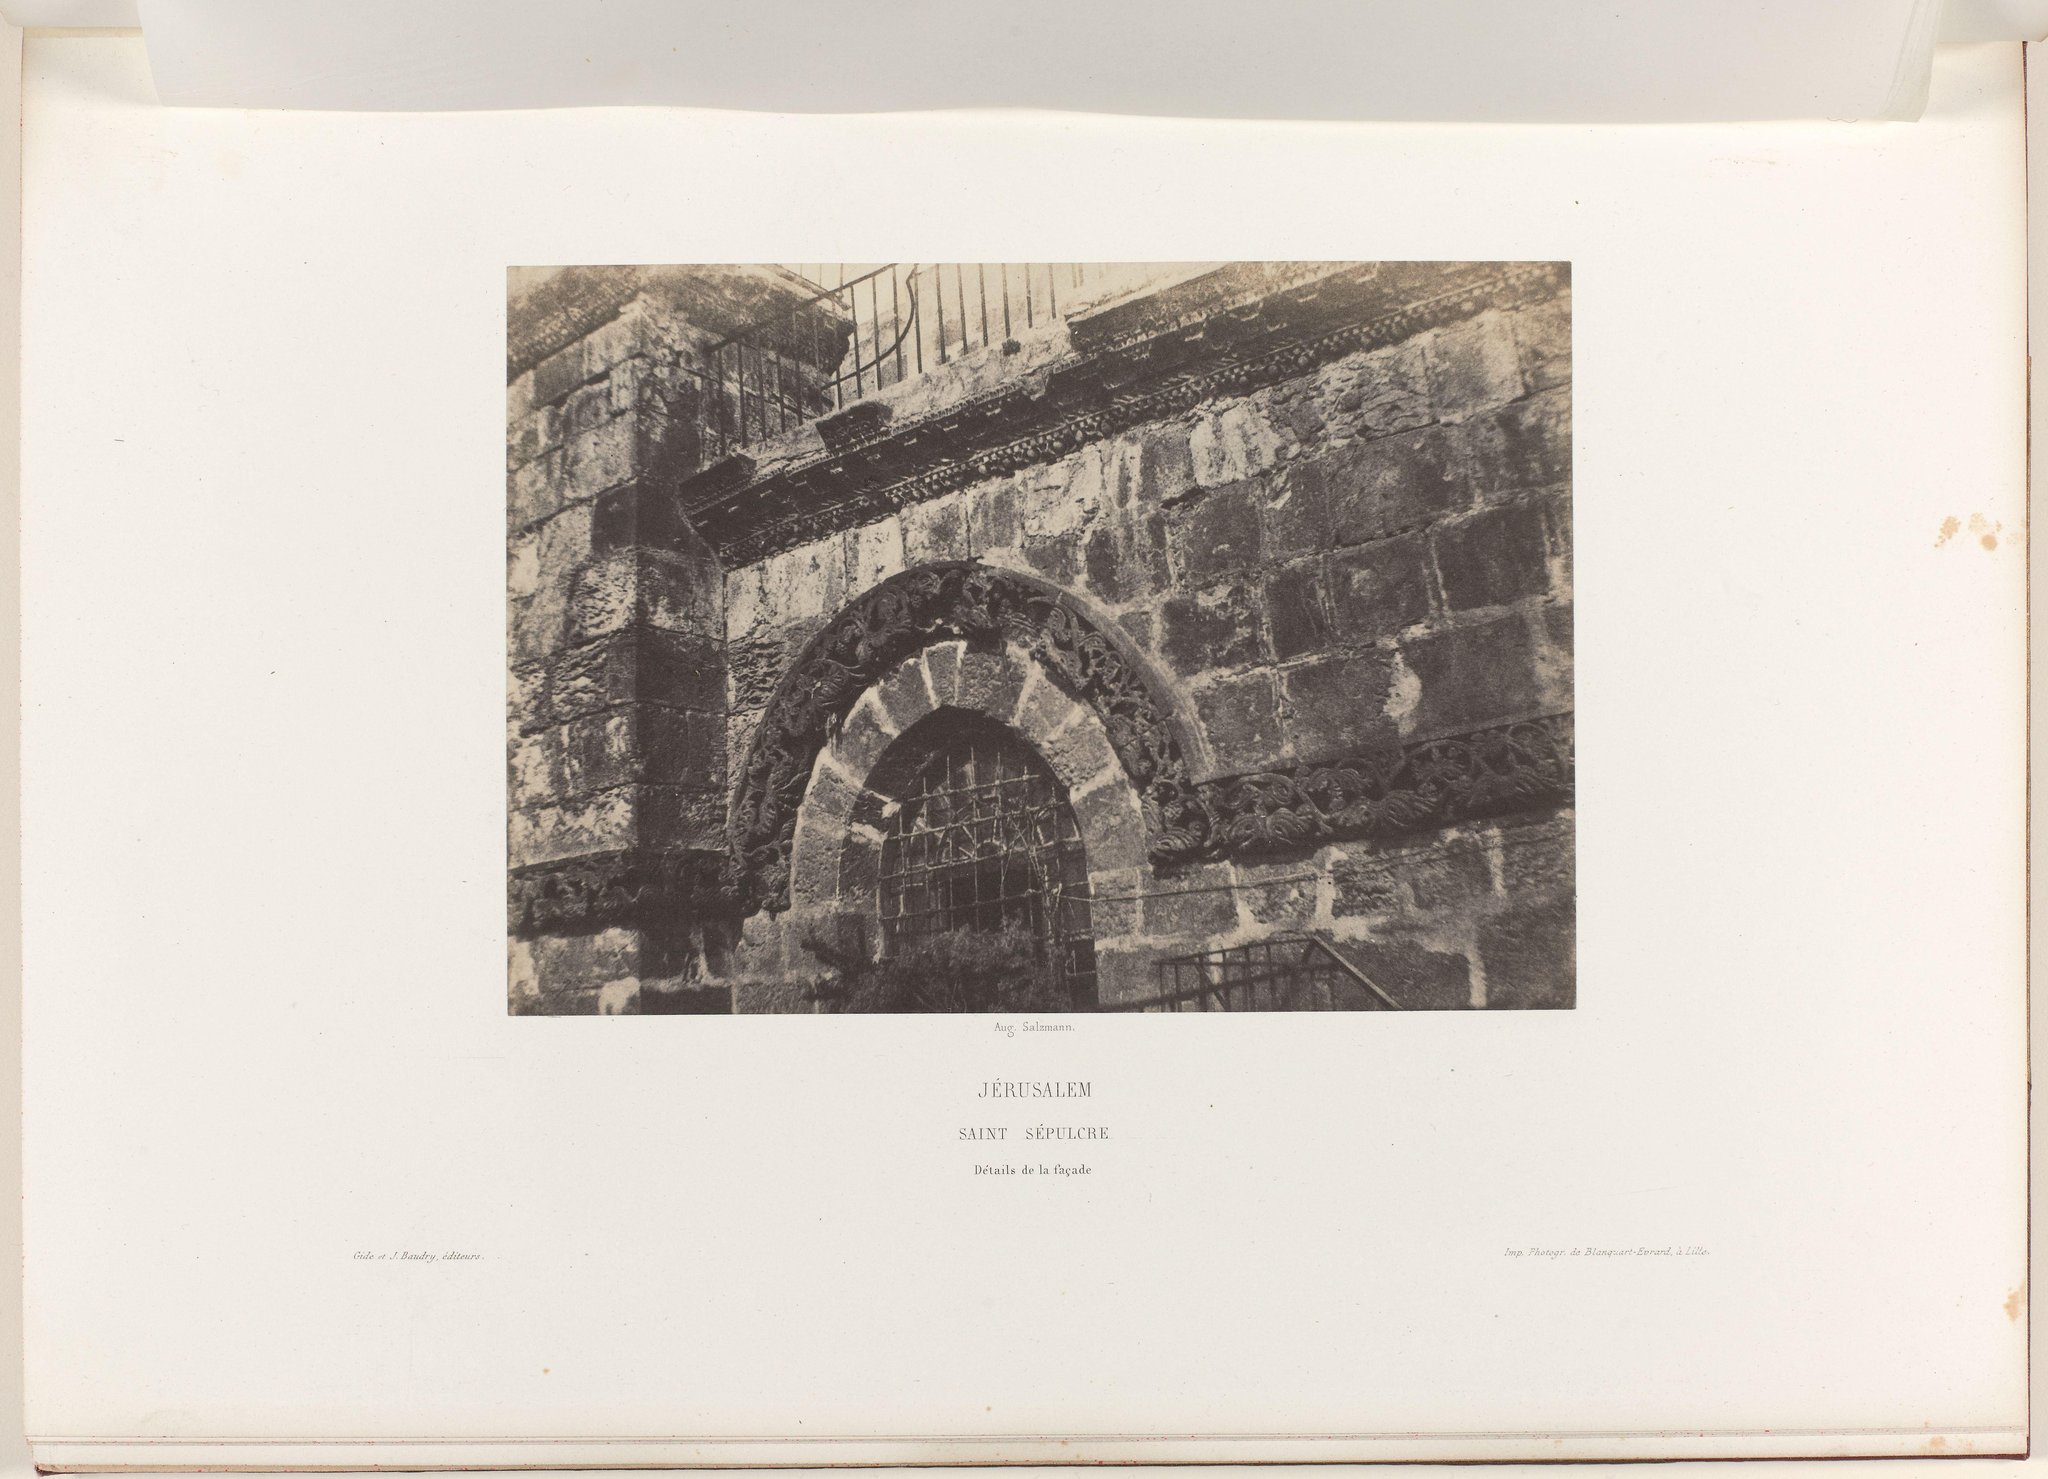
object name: photograph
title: Detail van een venster van de Heilig Grafkerk, Jeruzalem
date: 1854-1856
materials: cardboard, paper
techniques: salted paper print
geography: jerusalem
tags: window, parts of church exterior and annexes: façade